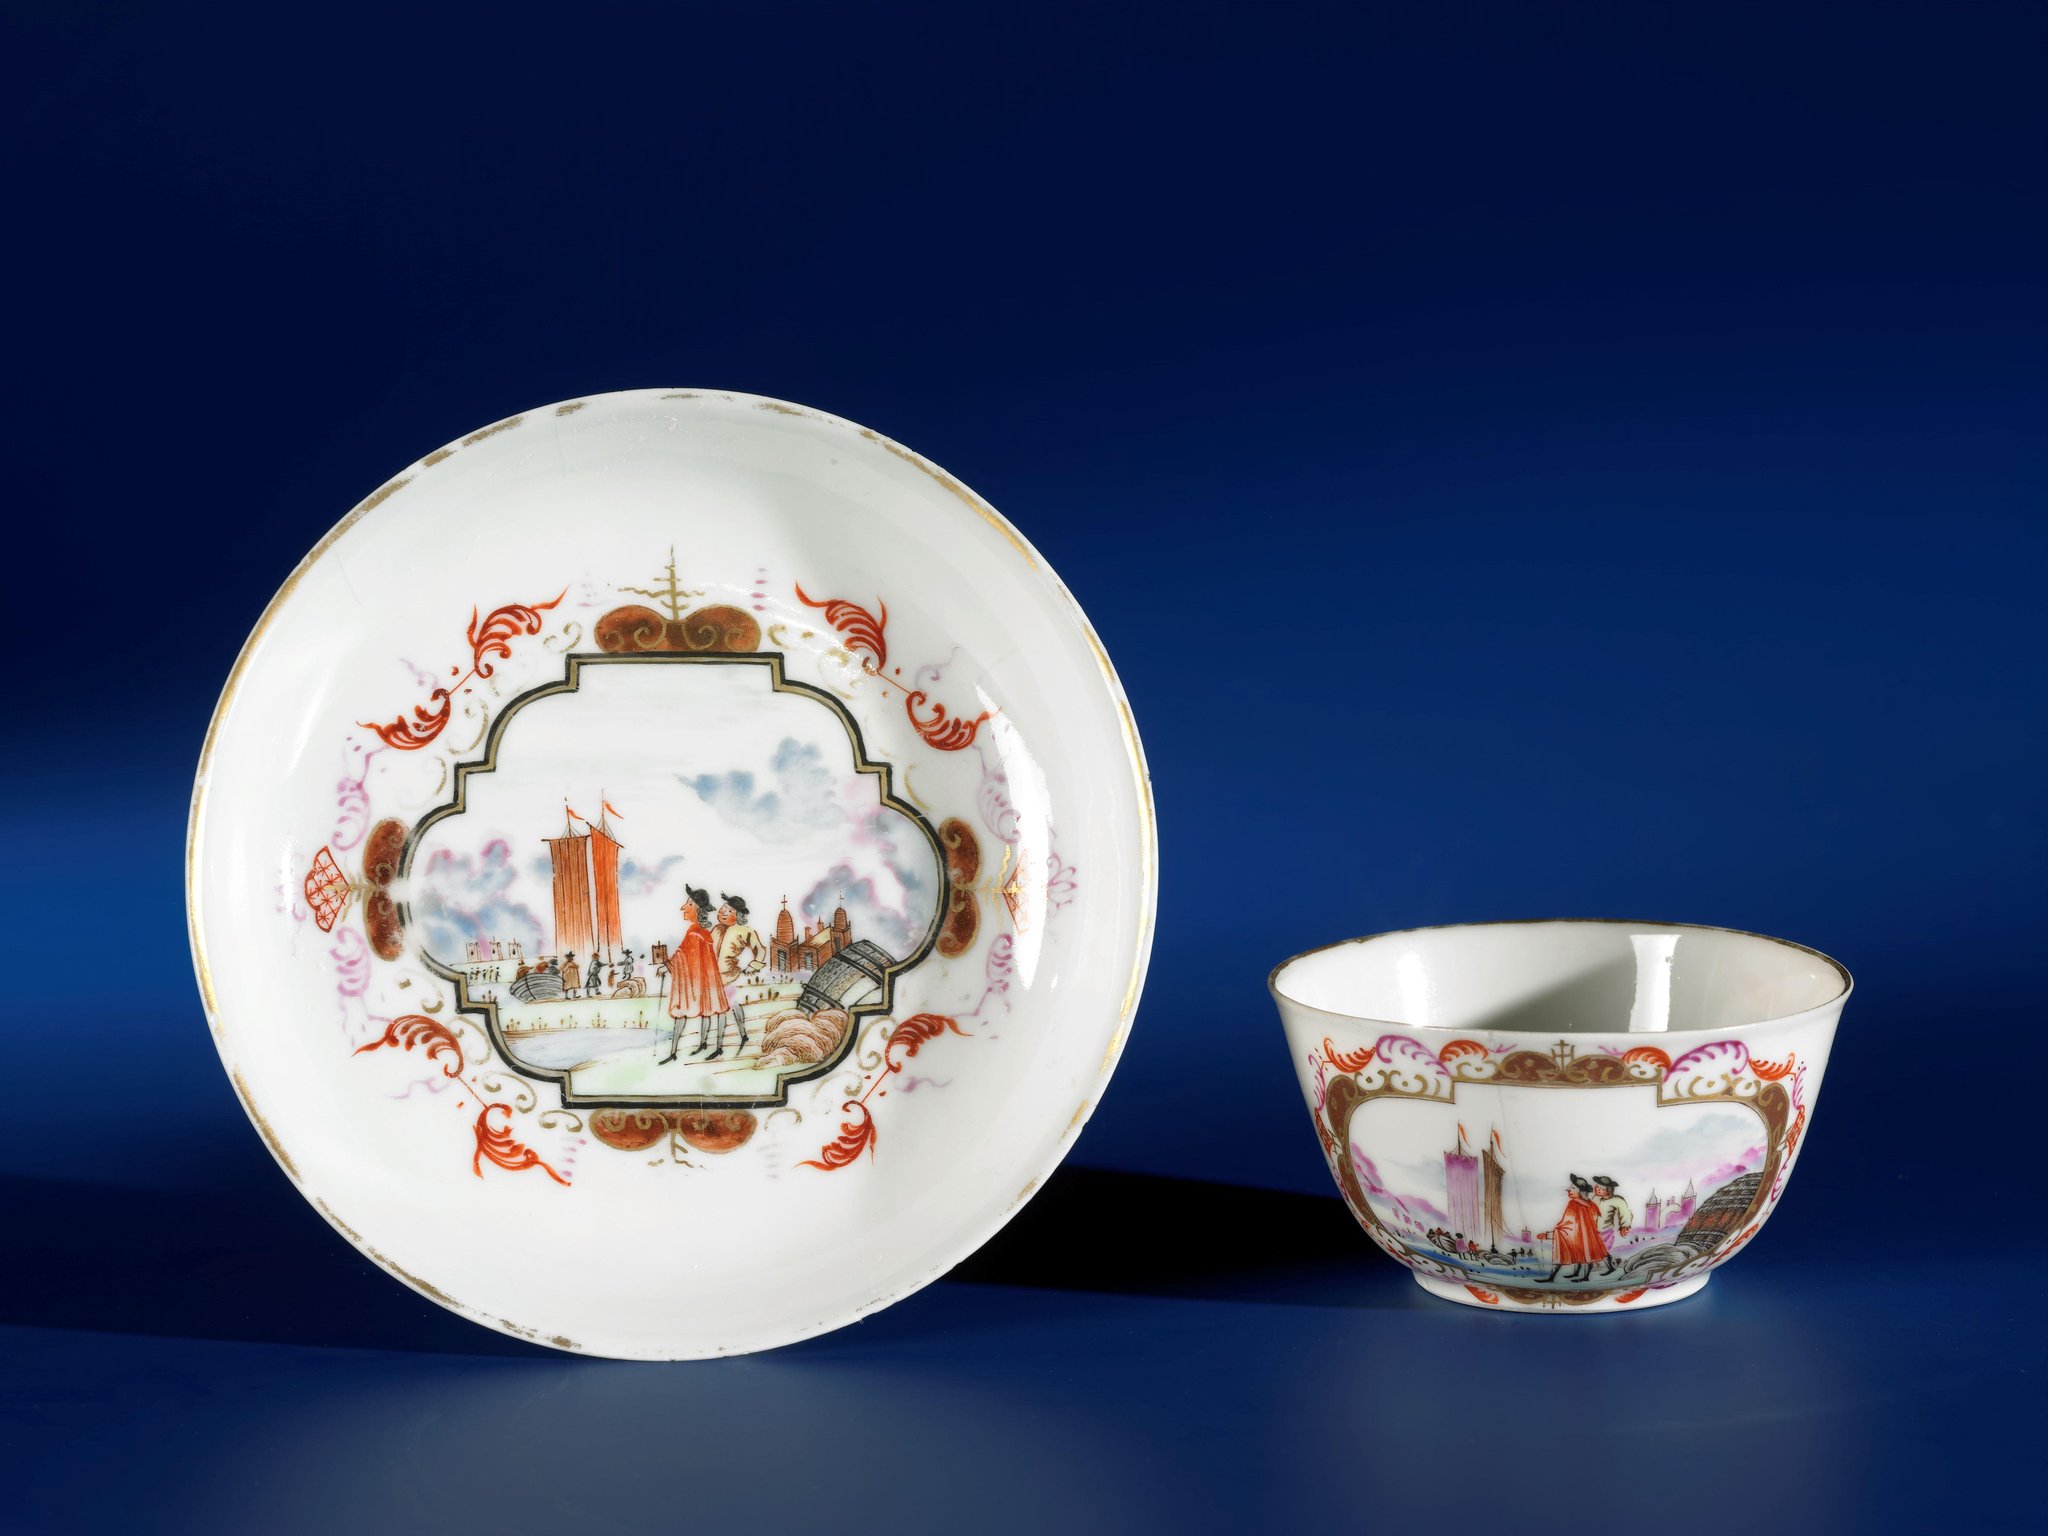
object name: kop en schotel, kop en schotel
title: Bell-shaped cup with two European men at different seaports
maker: Anonymous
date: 1750-1774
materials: glaze, gold, paint, porcelain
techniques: firing, gilding, turning, vitrification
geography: china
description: Wijd uitlopende kop en schotel op een voetring, gedecoreerd in emailkleuren met een voorstelling van een havengezicht geschilderd binnen een cartouche. Op de voorgrond zijn kooplieden te zien op de kade, op de achtergrond enkele schepen. Verschillende variaties van deze havengezichten zijn bekend.